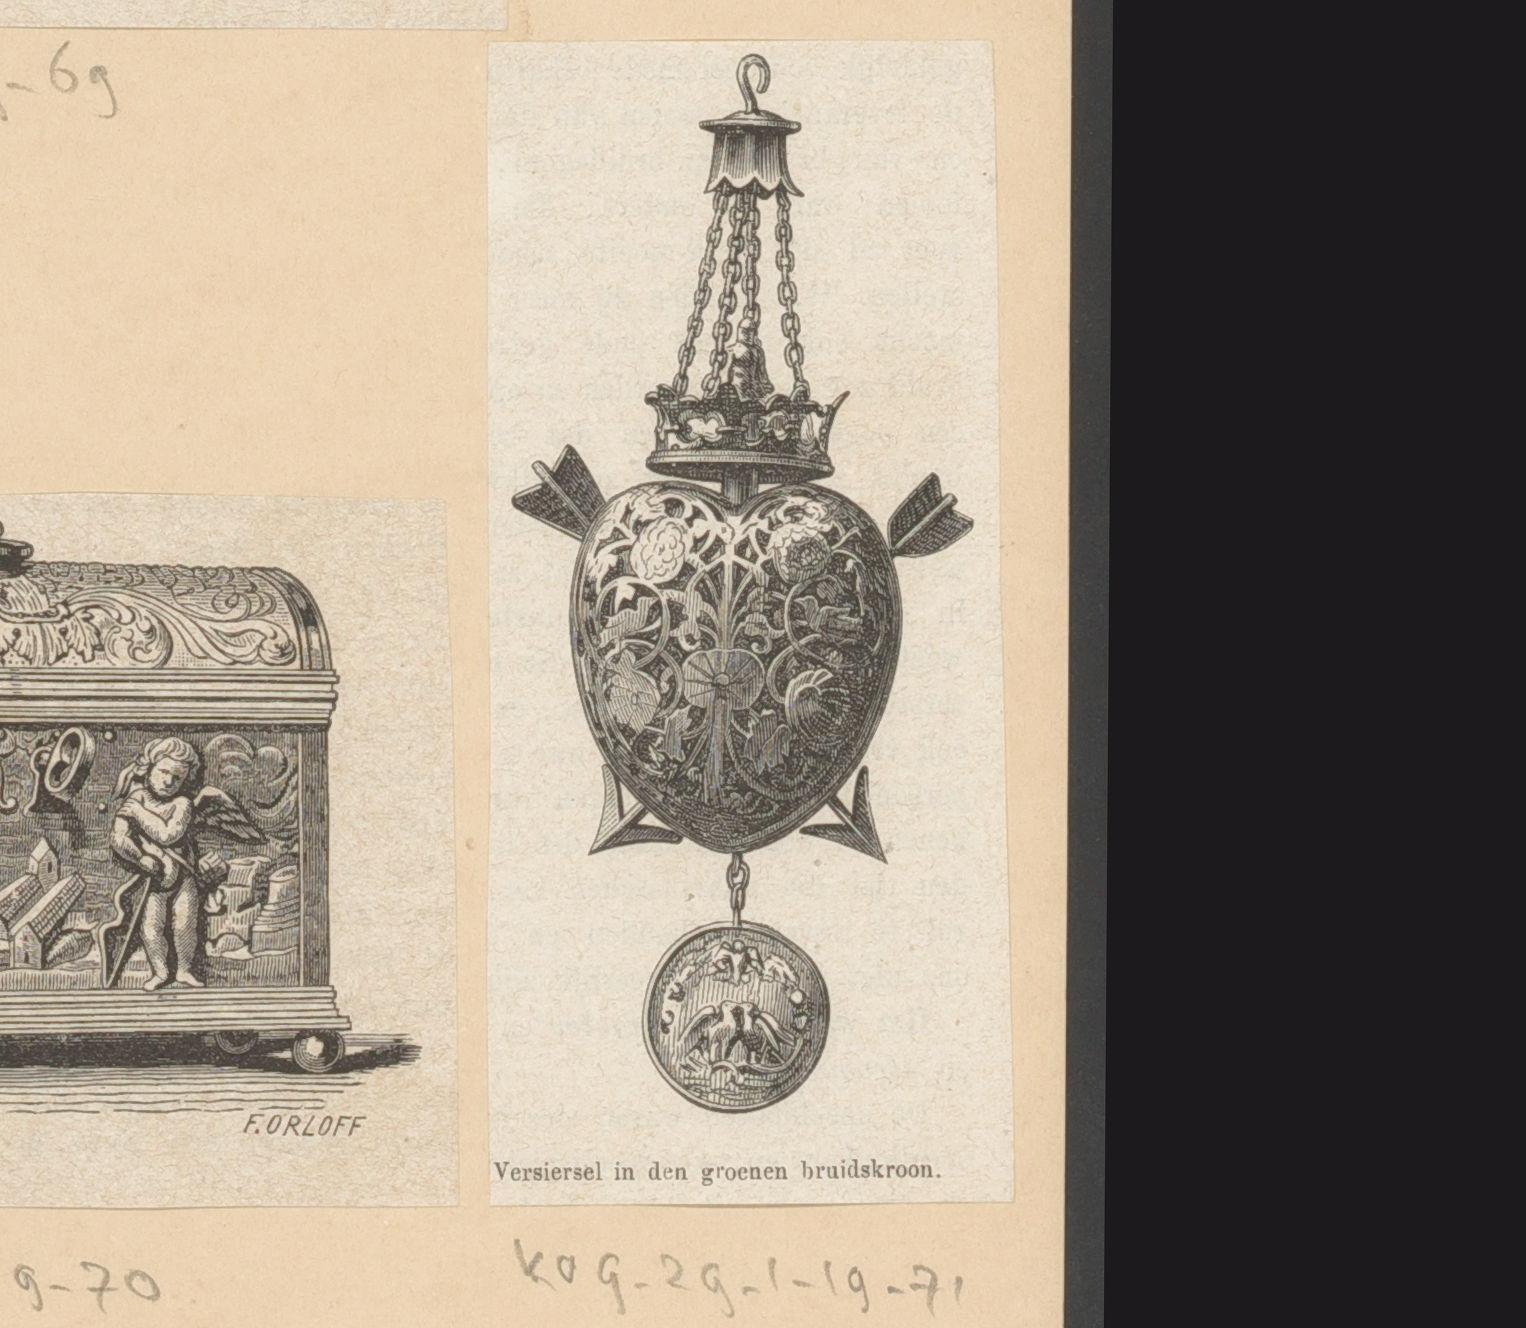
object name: print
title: Versiersel in den groenen bruidskroon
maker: Anonymous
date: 1850-1899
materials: paper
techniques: engraving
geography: netherlands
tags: bridal wreath, bridal chaplet, pomander, musk ball - aa - (for) women, wedding-gift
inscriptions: collector's mark, collector's mark: Lugt 1641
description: Metalen object, mogelijk een pomander, in de vorm van een hart doorboord met twee pijlen. Onderdeel van een bruidskroon. Uitgeknipte illustratie geplakt op een blad. Onderwerpsrubrieken binnen de Atlas Zeden en Gewoonten: Des Menschen Begin, Midden en Einde. Bruiloft en huwelijk.